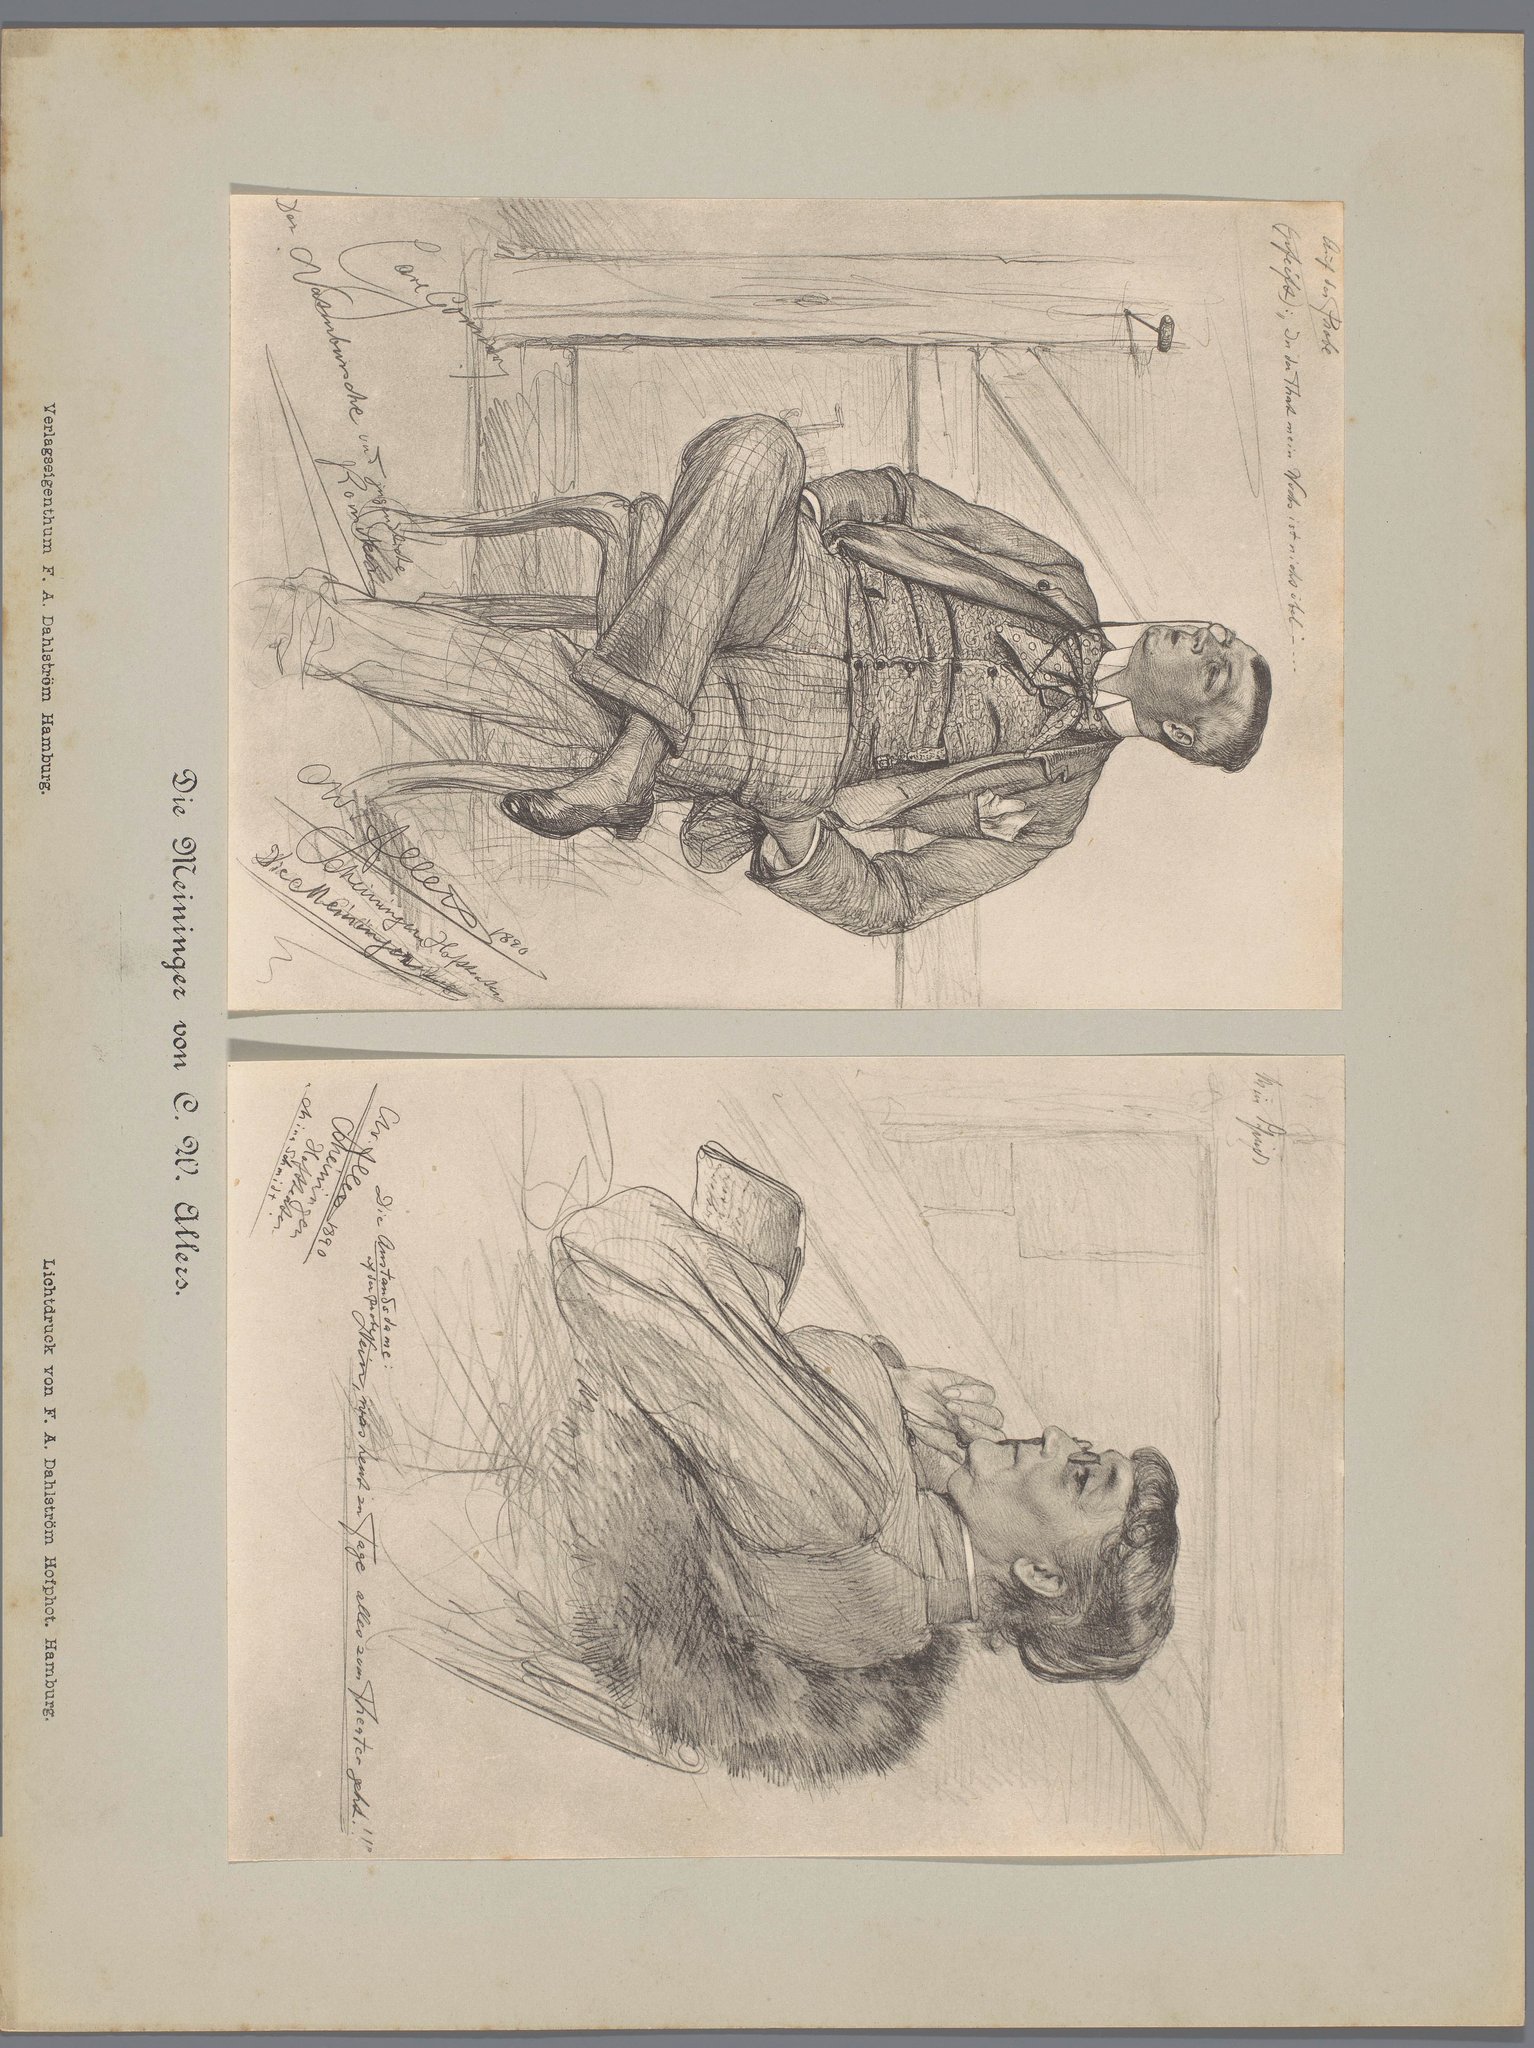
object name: reproduction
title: Die Meininger von C. W. Allers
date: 1890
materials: paper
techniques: photograph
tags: monocle, single lorgnette, portrait of actor, actress